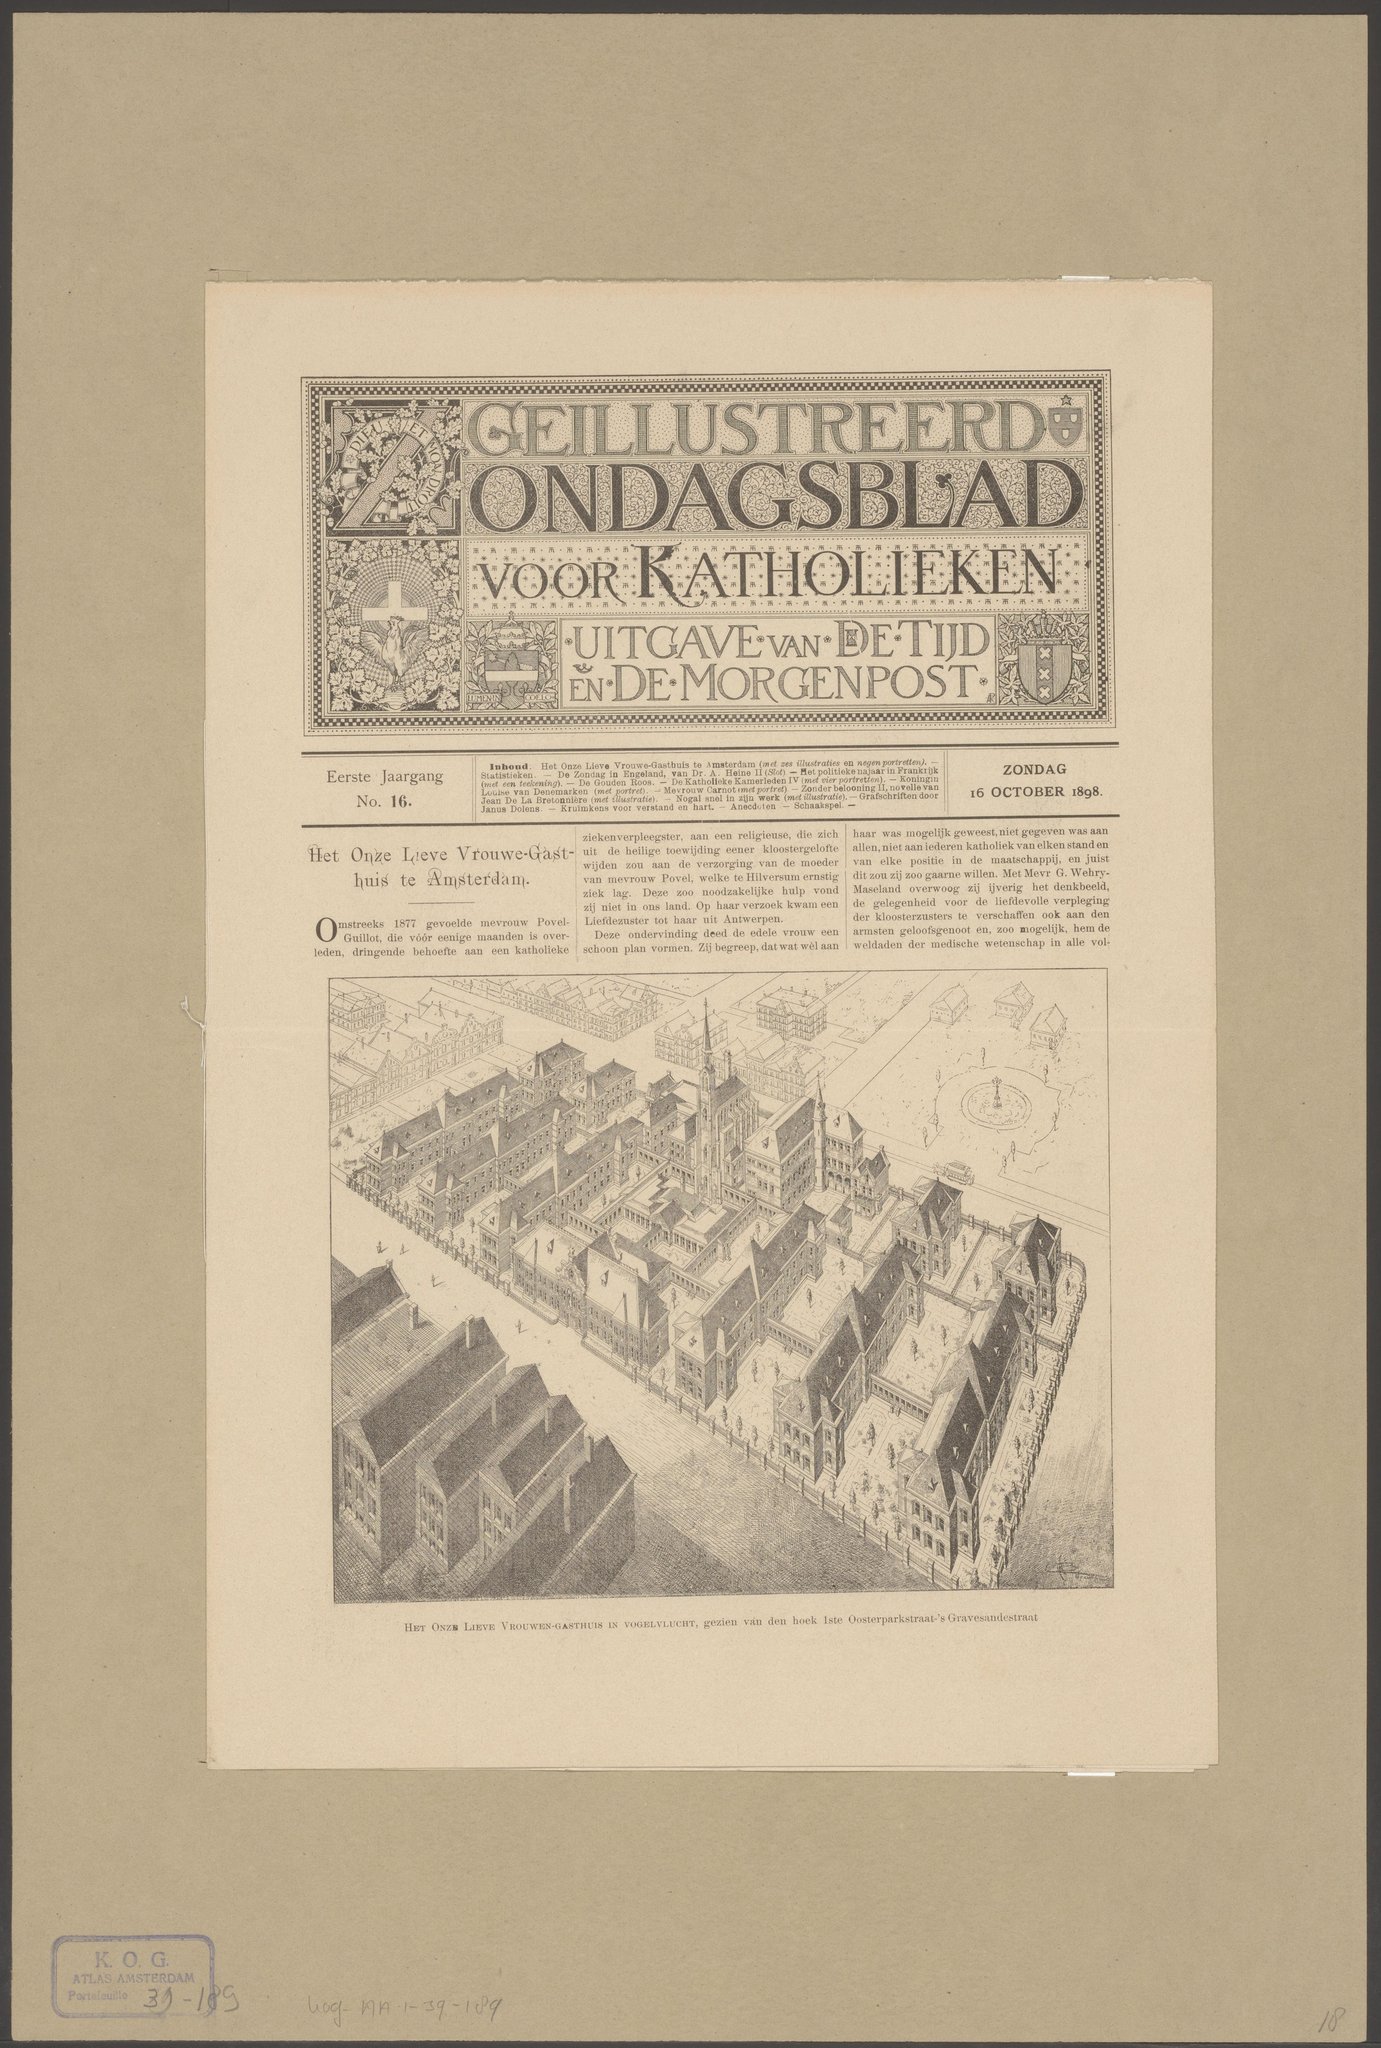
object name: magazine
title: Geïllustreerd Zondagsblad voor Katholieken, 16 oktober 1898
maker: Anonymous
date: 1898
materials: paper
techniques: letterpress printing, line block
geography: amsterdam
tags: haarlem, the hague, politician, hoorn (north holland), utrecht, amsterdam, nijmegen, rome, priest, herman johannes aloysius maria schaepman, historical persons, interior of church, hospital, political caricatures and satires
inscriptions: collector's mark: Lugt 1641b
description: Object bestaat uit twee samengebonden bifolia. Onderwerpsrubriek binnen de Atlas Amsterdam: Armwezen en liefdadige instellingen: V. Ziekenhuizen: O.L. Vrouwe Gasthuis.